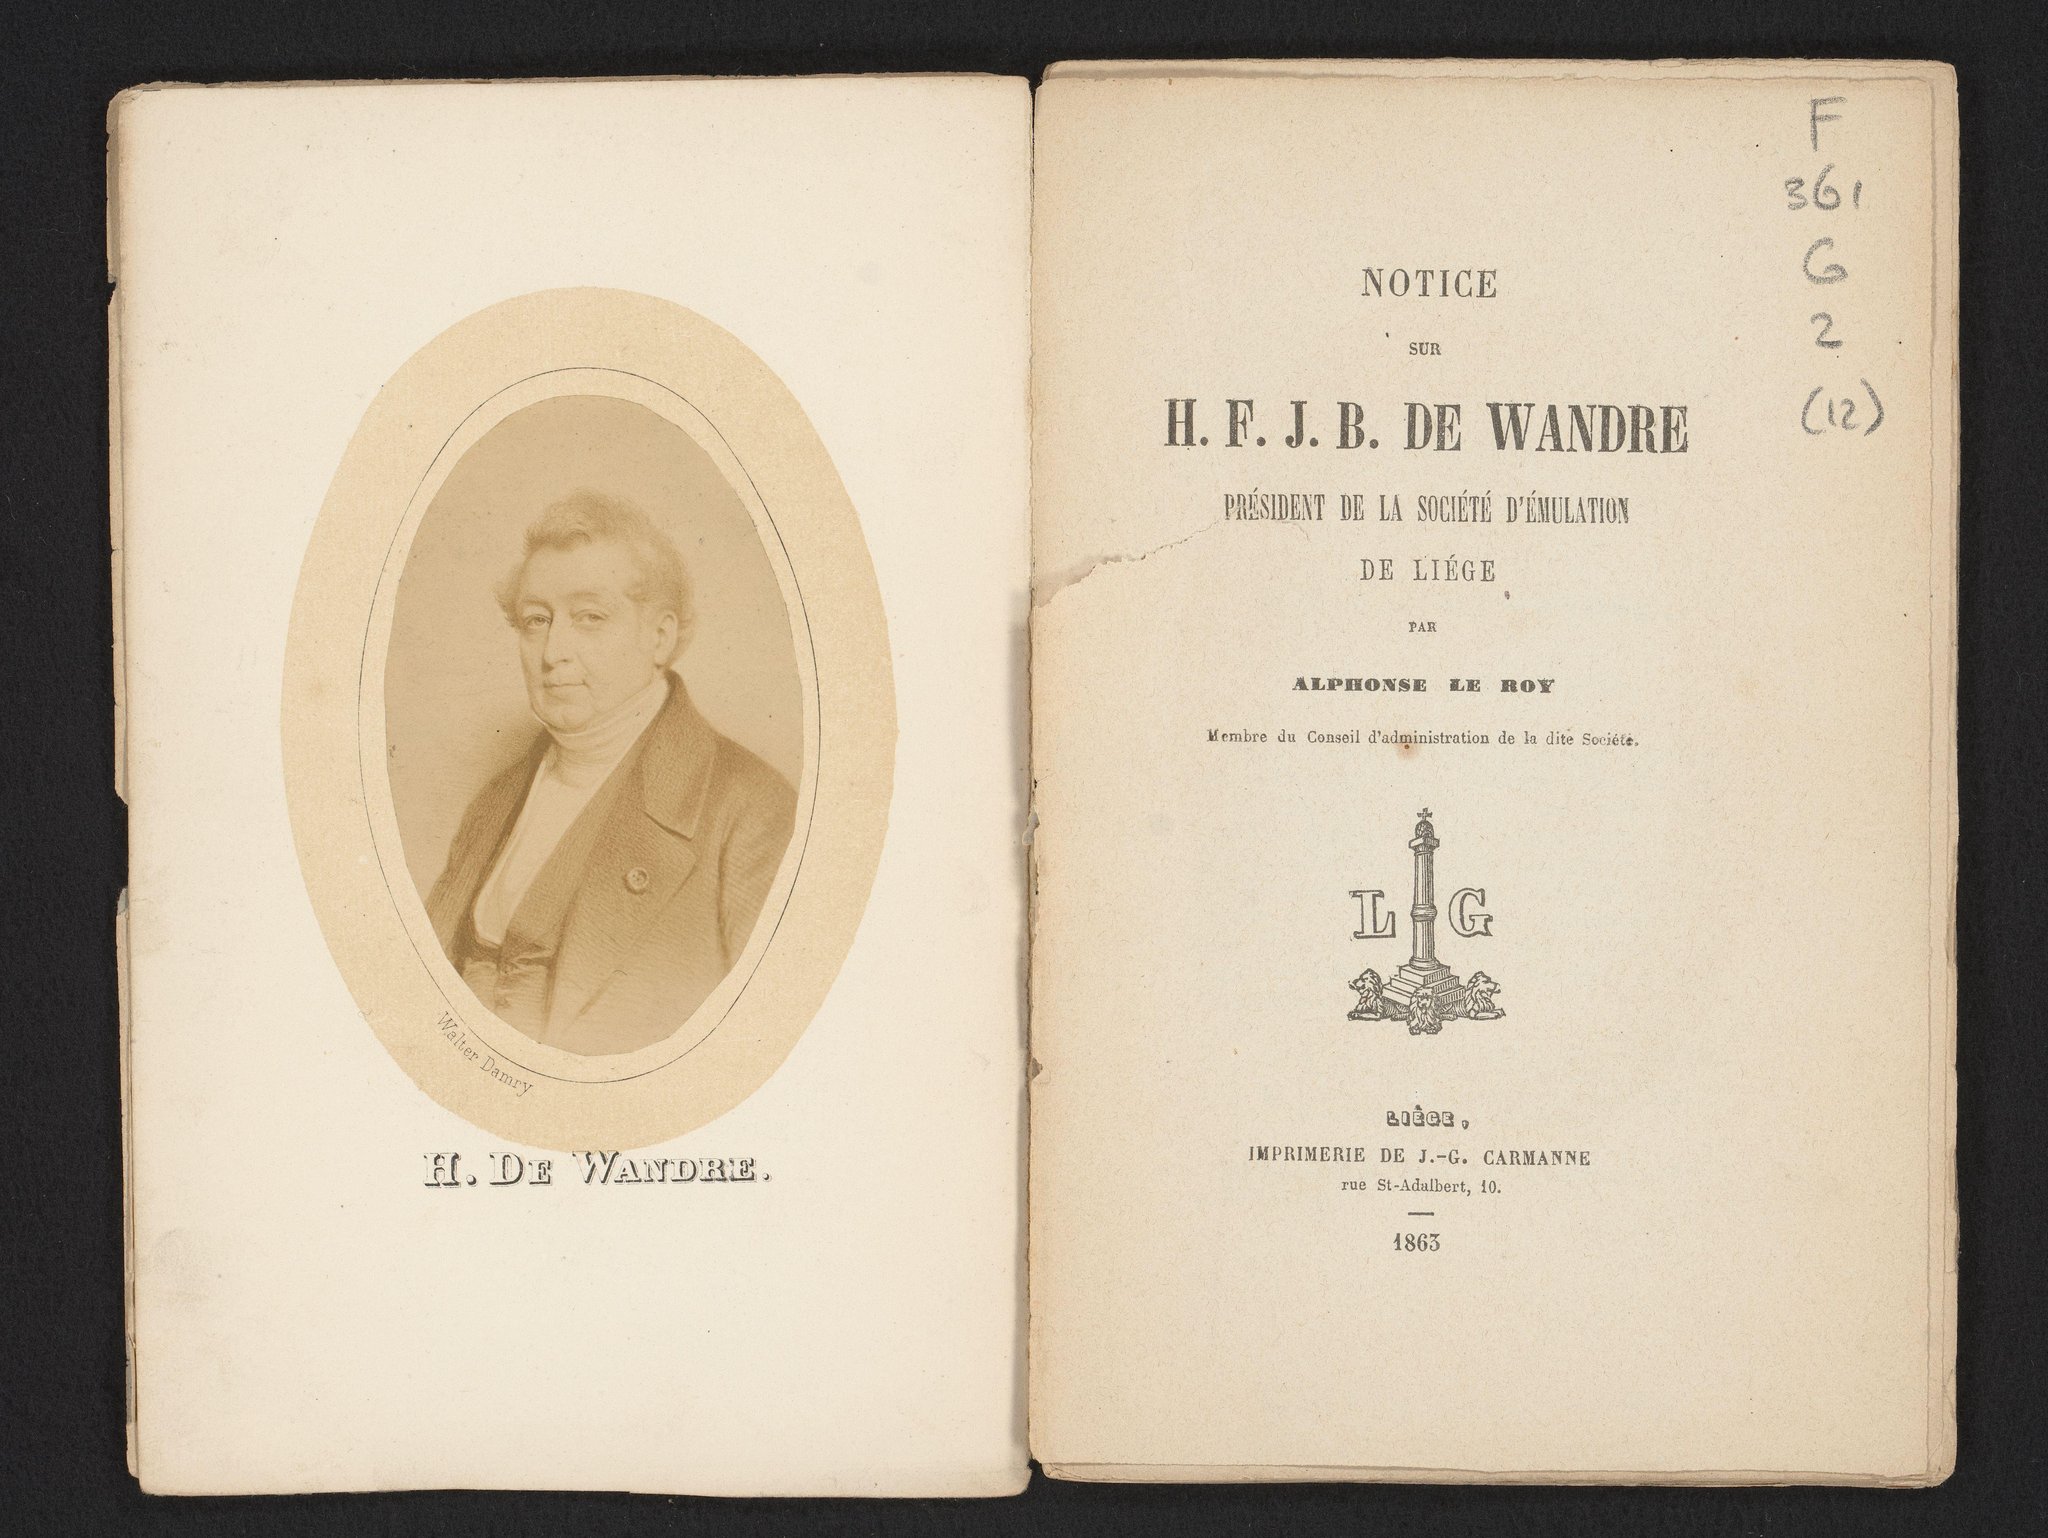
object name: book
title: Vierge sculptée du XVme siècle découverte à Havré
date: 1883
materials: paper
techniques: photoaquatint, printing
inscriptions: date: ‘APR 1987’